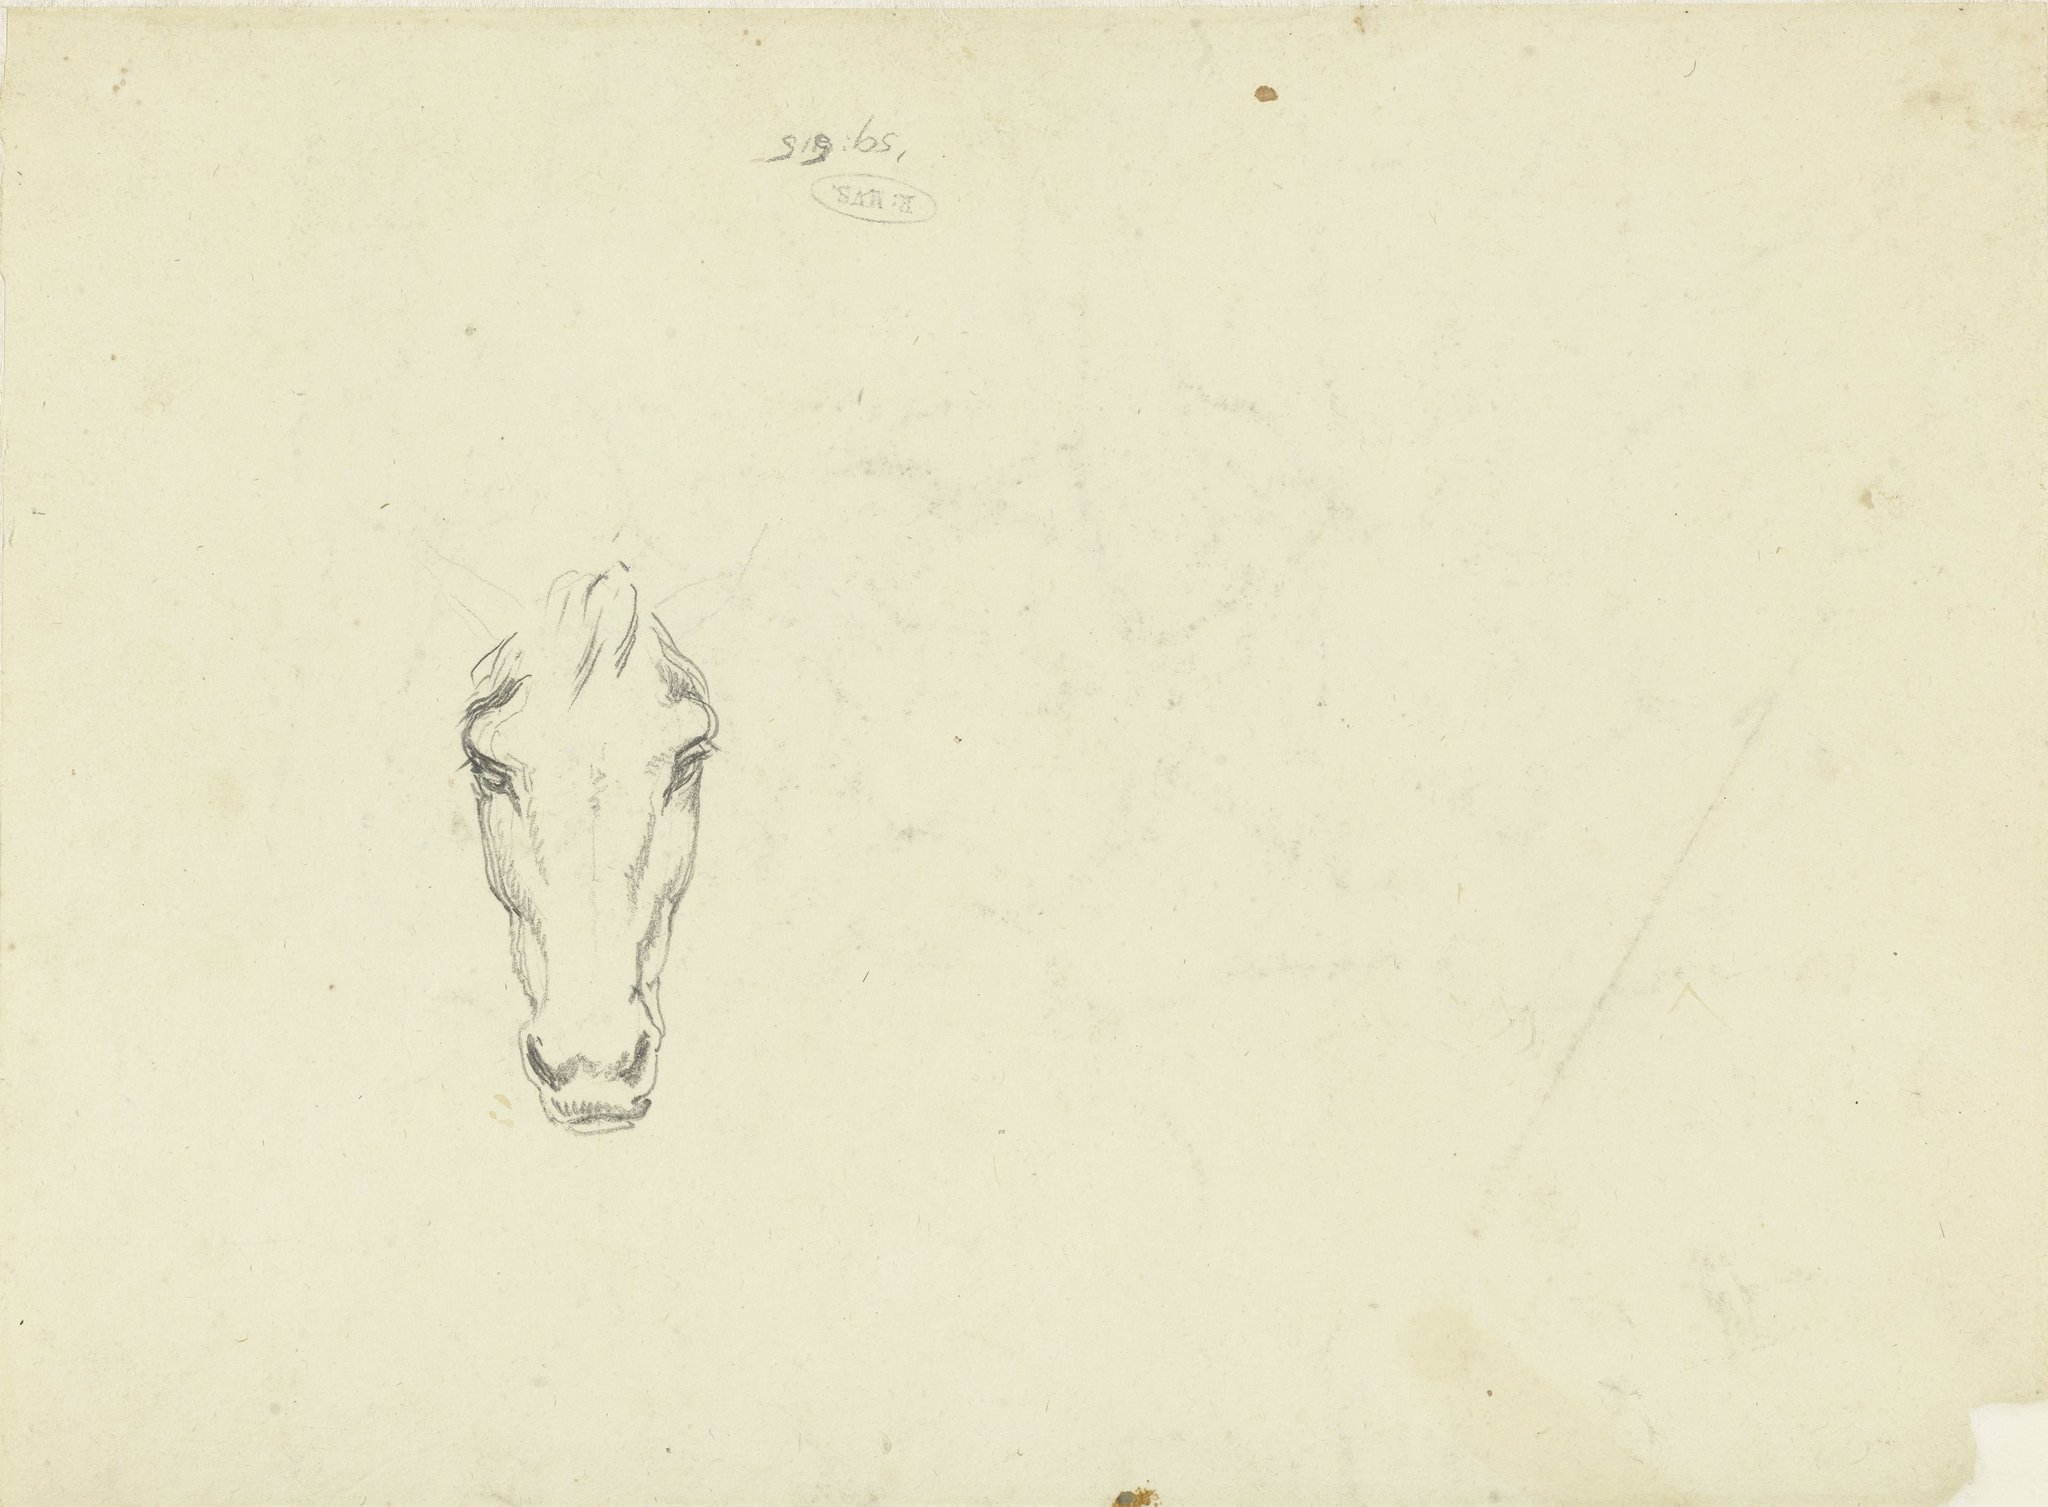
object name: drawing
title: Paardenkop, van voren gezien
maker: hendrik voogd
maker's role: draughtsman, painter, print maker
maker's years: 1768-1839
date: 1788-1839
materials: paper, pencil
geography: rome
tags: horses and kindred animals